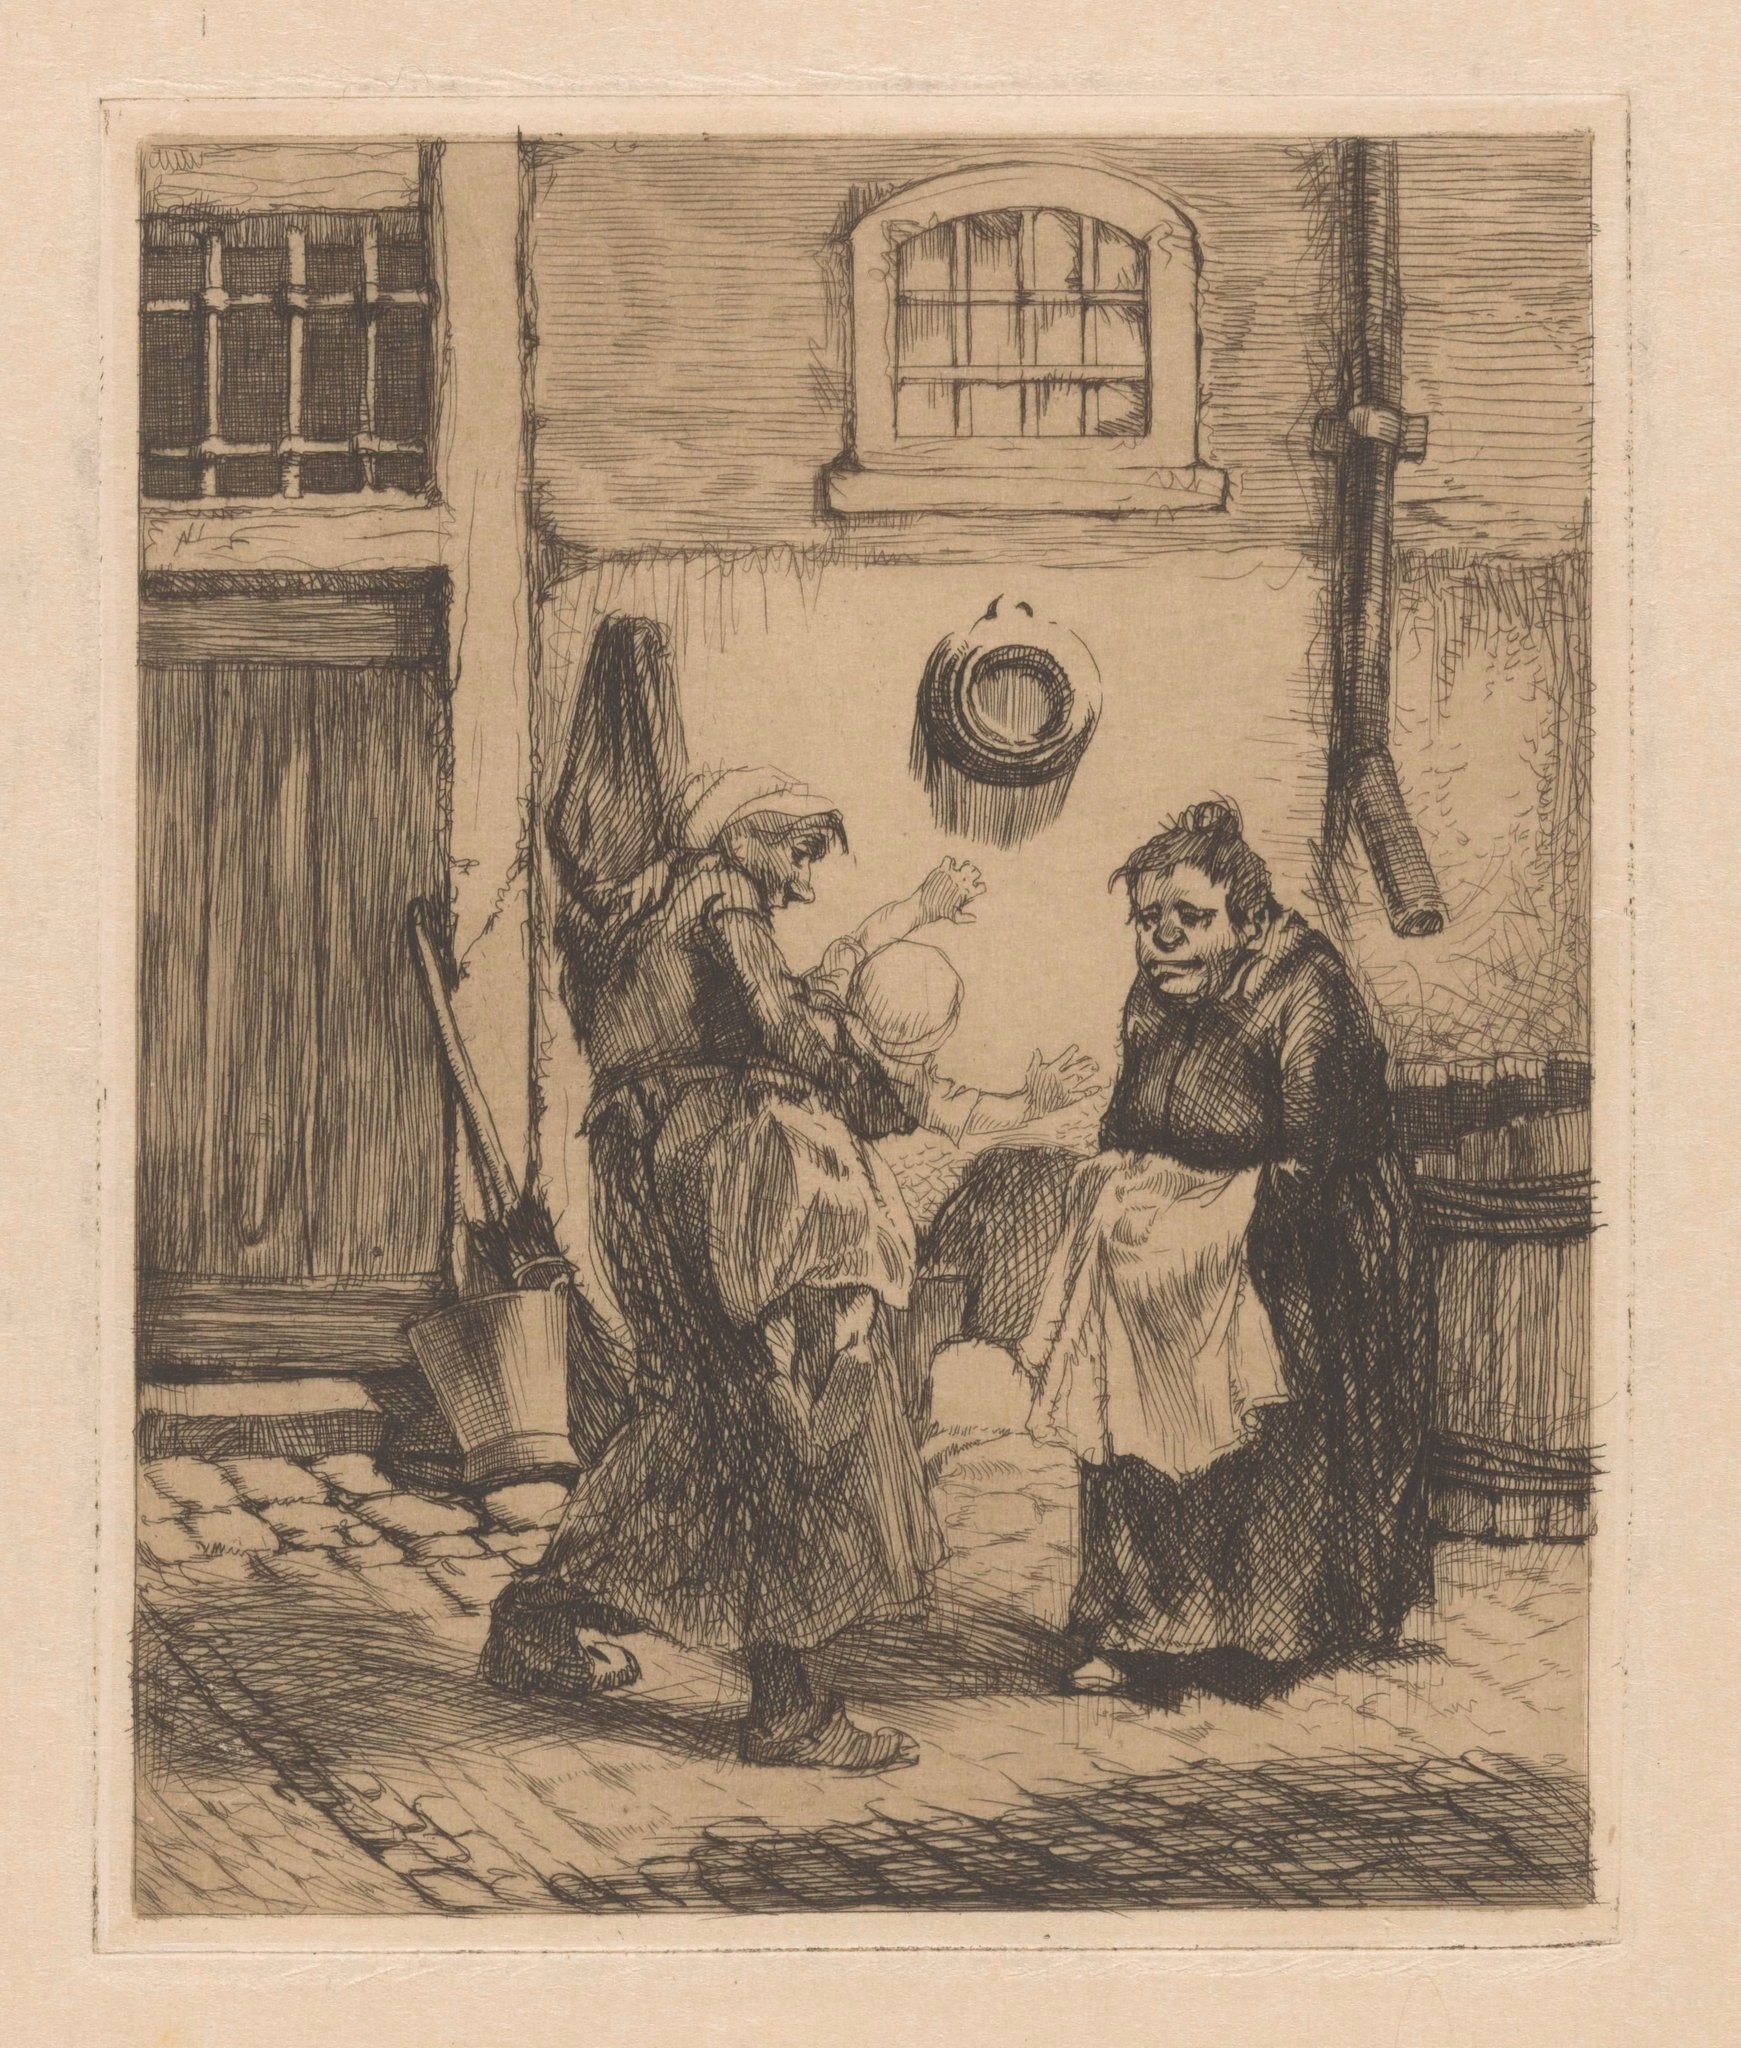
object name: print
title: Volksbuurtje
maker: johannes josephus aarts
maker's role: draughtsman, print maker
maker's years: 1871-1934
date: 1881-1934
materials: paper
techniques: etching, intaglio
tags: carrying a child on the hip, astride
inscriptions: collector's mark: Lugt 2760, collector's mark: Lugt 2228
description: Twee vrouwen staan in een met kasseien verharde straat. Een van hen tilt een kind op dat beide armen in de lucht uitstrekt. Op de achtergrond de gevel van een huis, met daartegen een regenpijp en regenton.